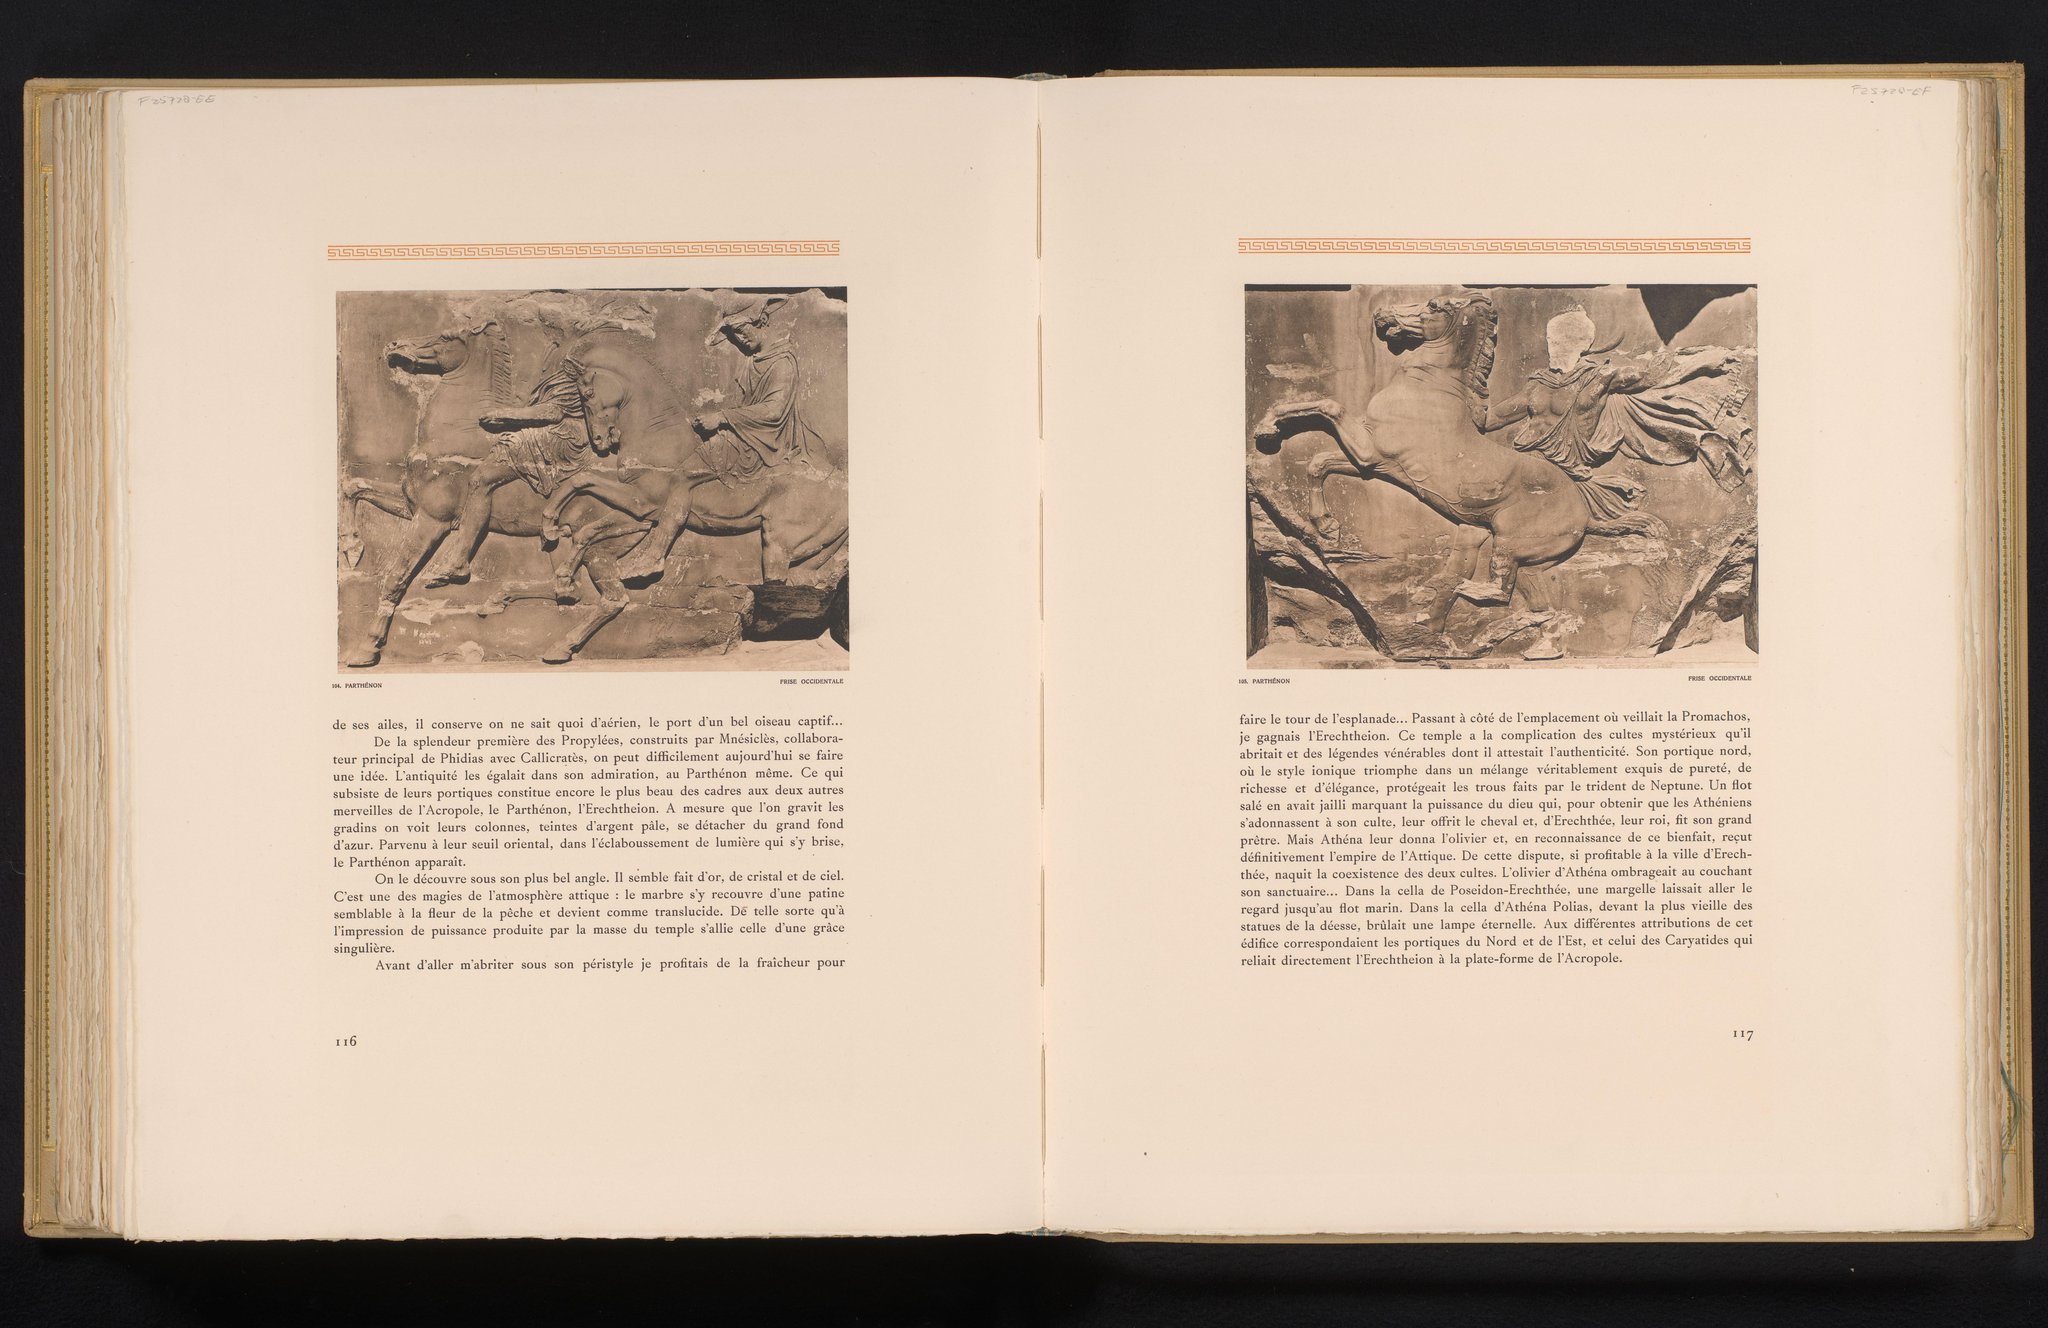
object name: photomechanical print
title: Reliëf aan de westfries van het Parthenon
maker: frédéric boissonnas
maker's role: fotograaf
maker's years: 1858-1946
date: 1905-1910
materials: paper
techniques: photograph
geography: acropolis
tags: sculpture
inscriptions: number: ‘105.’